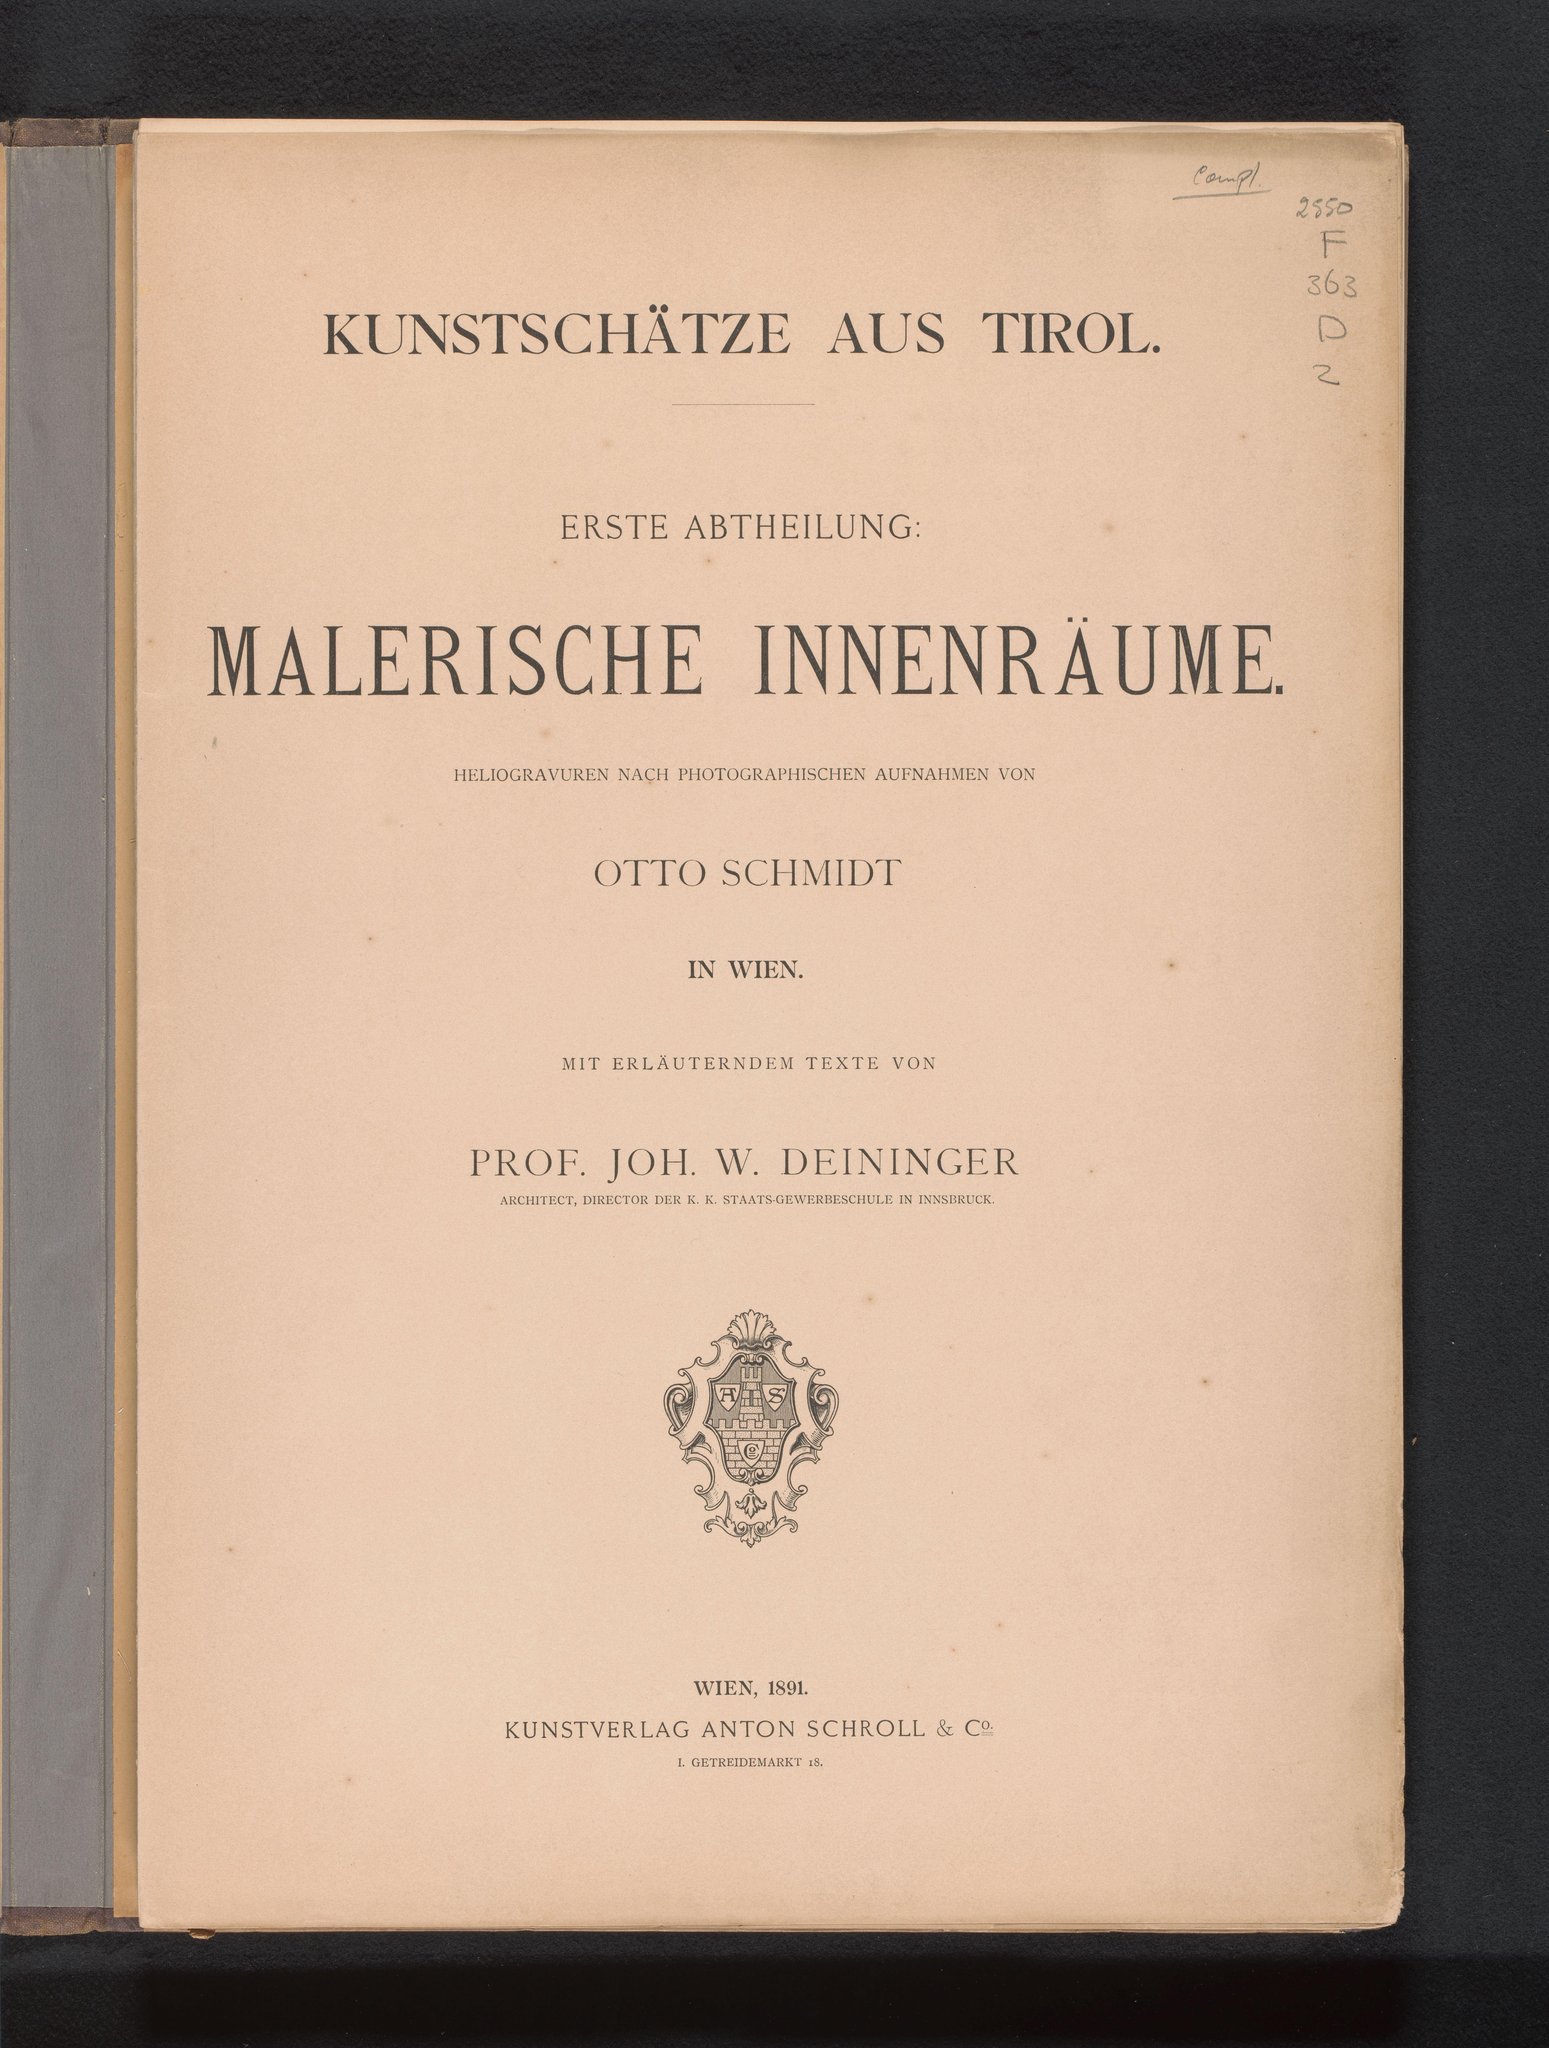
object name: wrapper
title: Kunstschätze aus Tirol / Heliogravuren nach photogr. Aufnahmnen von Otto Schmidt; mit erl. Texte von Joh. W. Deininger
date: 1891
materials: cardboard, linen, paper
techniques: photoaquatint, printing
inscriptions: annotation: ‘Compl.’, retailer's mark: ‘E. Lyon-Claesen/ Editeur/ 8, Rue Berckmans, 8./ Bruxelles.’, date: ‘JULY/ 1988’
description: Omslag met dertig prenten en drie tekstbladen.